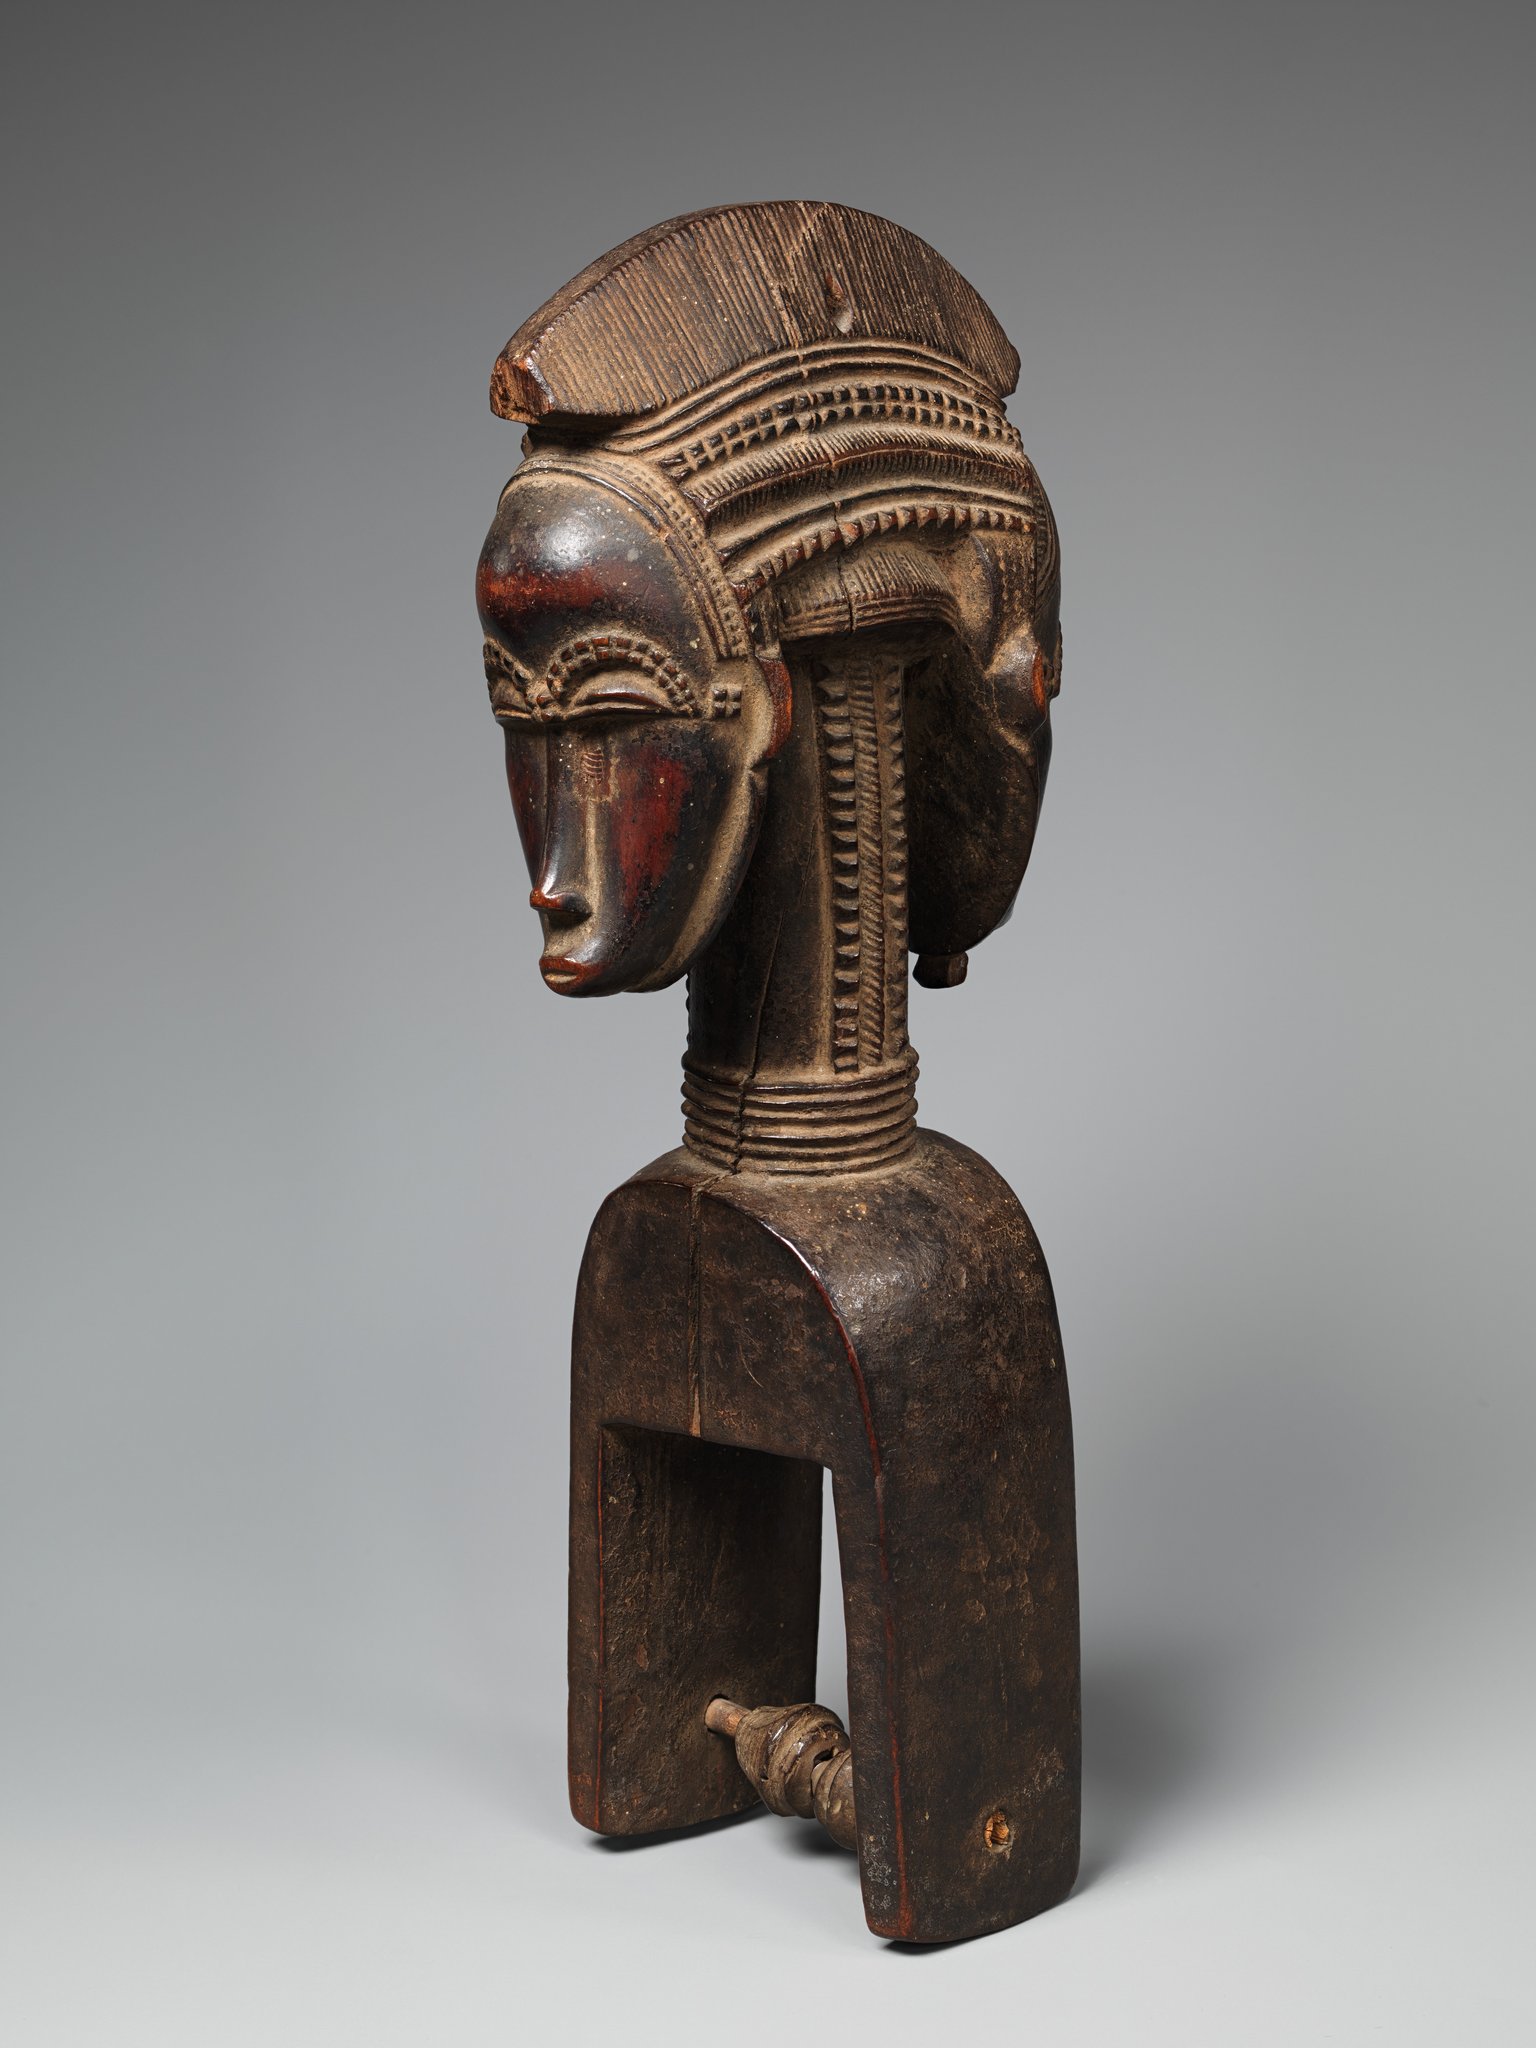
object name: heddle pulley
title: Heddle pulley with opposing faces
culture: baule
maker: baule artist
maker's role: artist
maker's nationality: baoulé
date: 1900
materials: wood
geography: côte d'ivoire